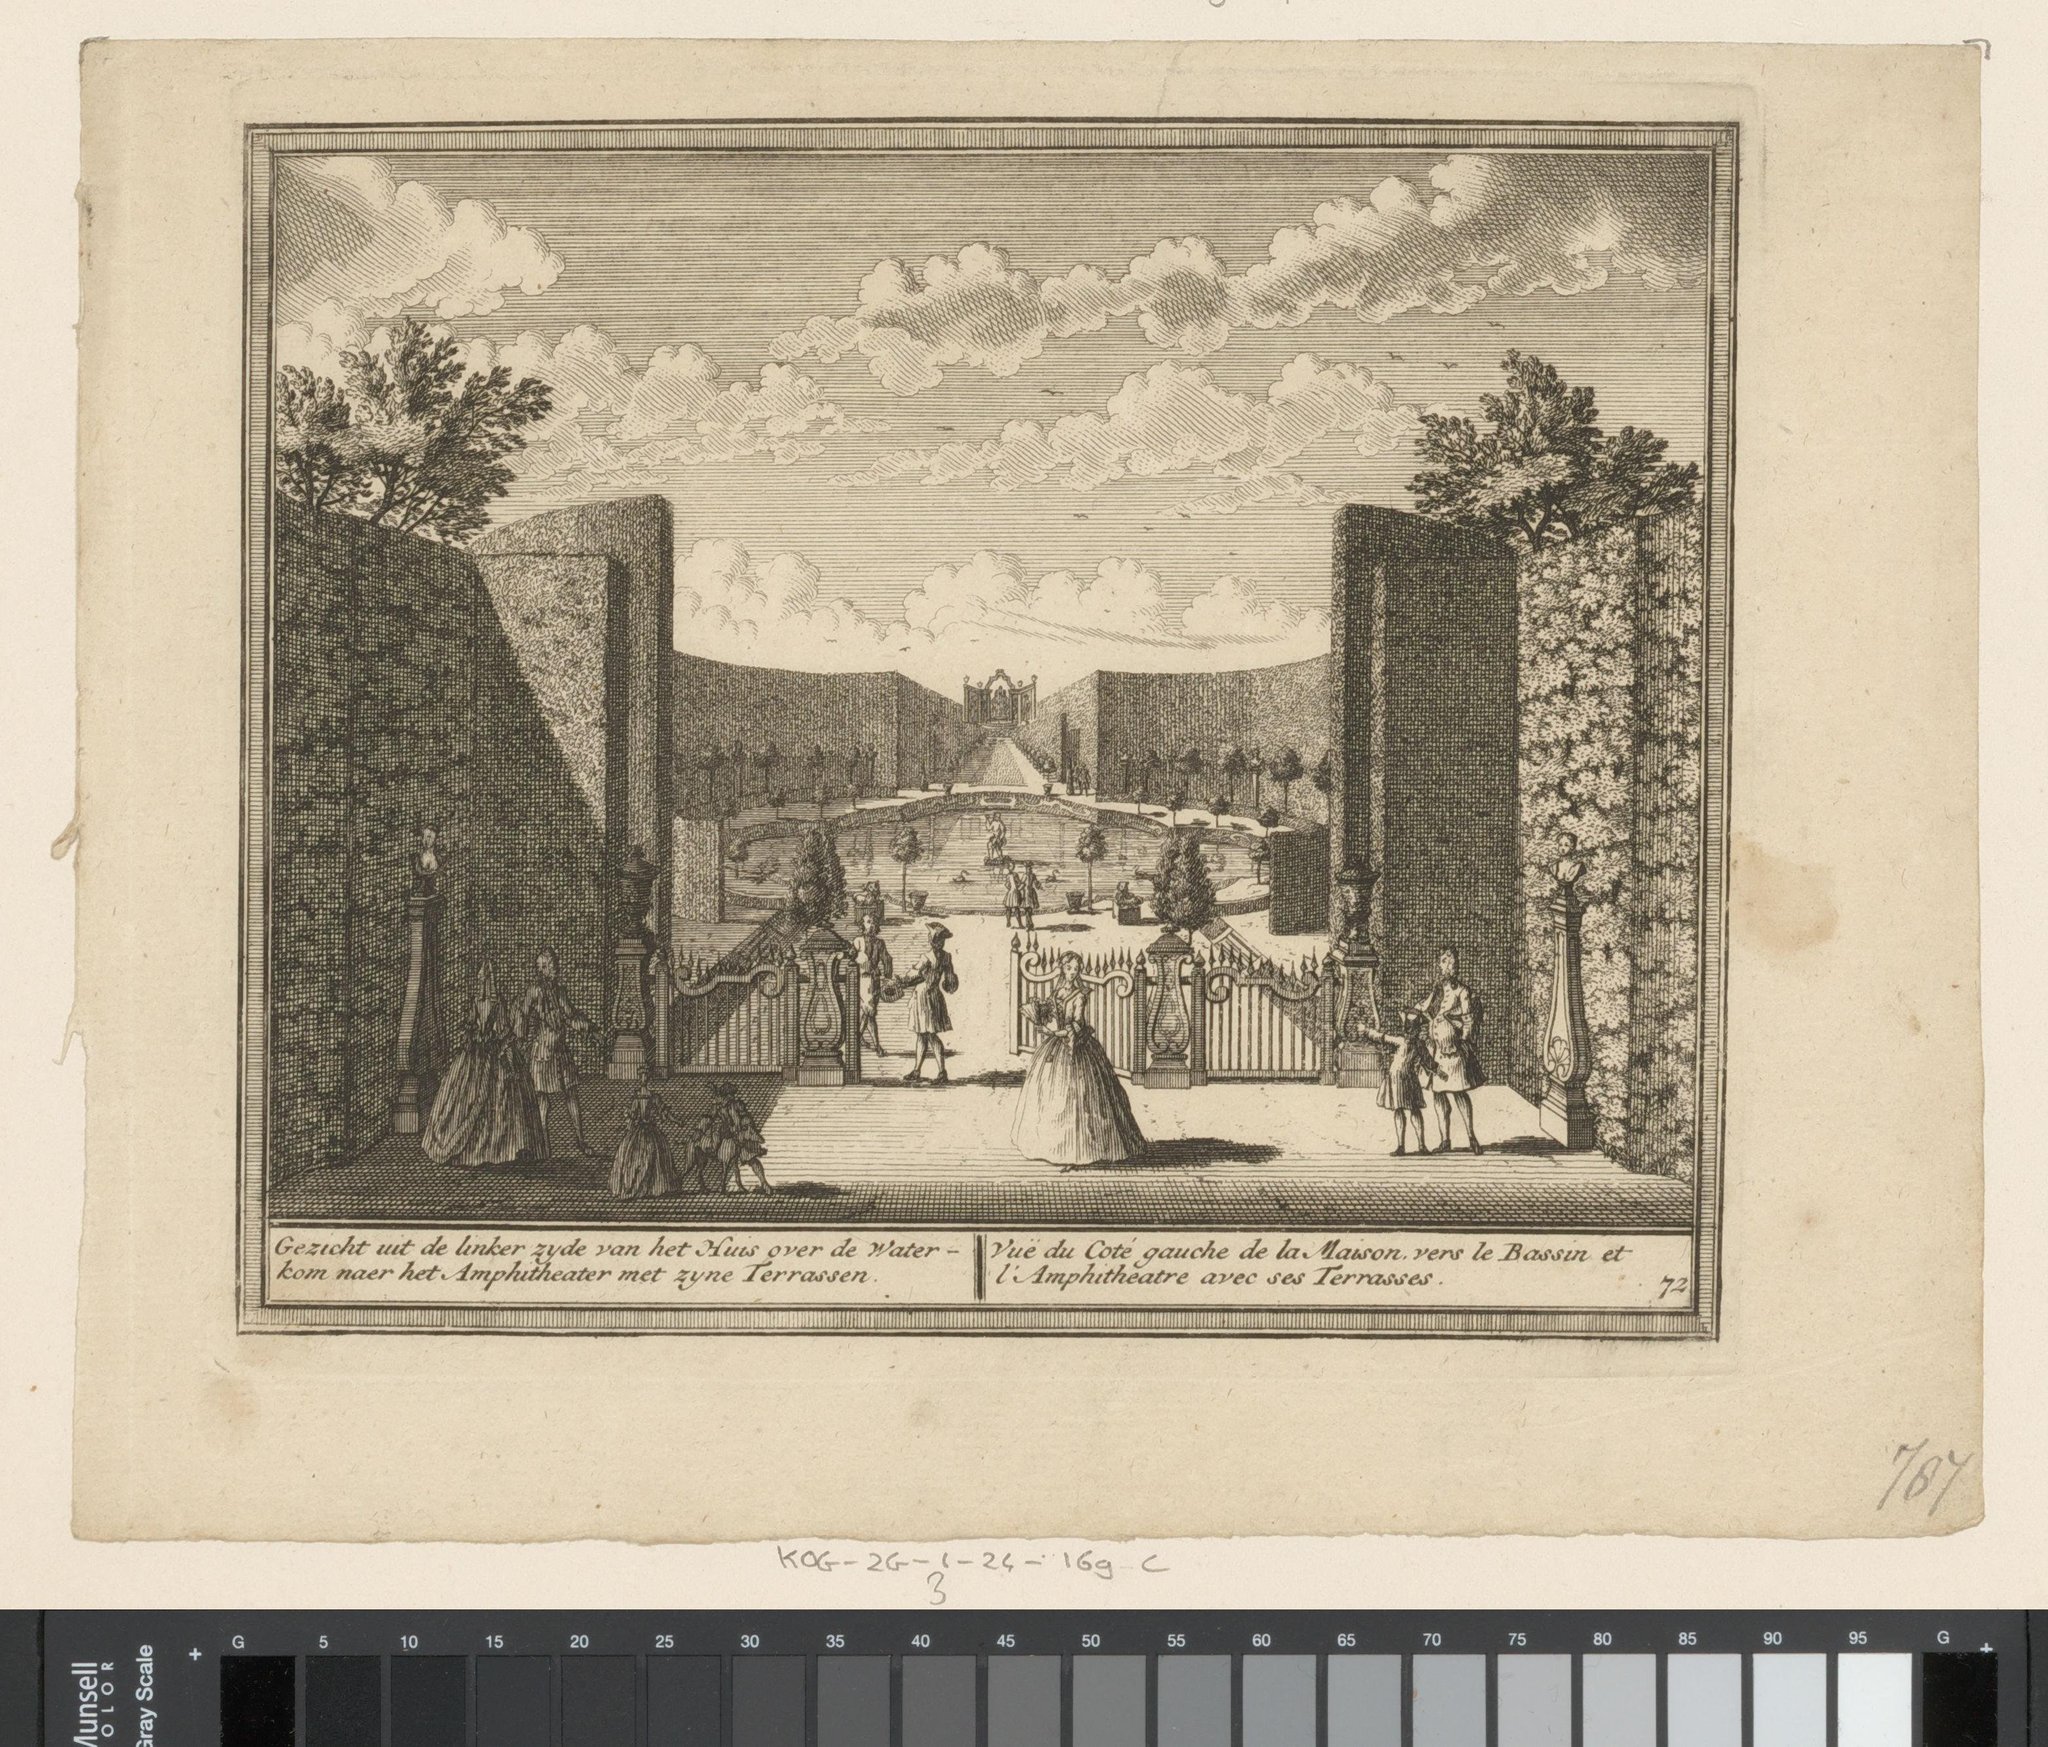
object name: print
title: Uitzicht over de vijver naar het amfitheater van Buitenplaats Velserhooft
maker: hendrik de leth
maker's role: draughtsman, print maker, publisher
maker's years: 1703-1766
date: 1729-1732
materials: paper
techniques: engraving, etching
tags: french or architectonic garden; formal garden, garden pond, country-house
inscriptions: stamp, stamp, collector's mark: Lugt 1641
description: Gezicht van uit het huis Velzerhooft, eigendom van Jacob du Peyrou Jansz, over de vijver naar het amphitheater. Rechtsonder genummerd: 72. Onderwerpsrubrieken binnen de Atlas Zeden en Gewoonten: Zeden en Gewoonten in Engeren Zin, De Woning, Oude Nederlandsche Tuinkunst. De 18de eeuw. Tuinen in Kennemerland, le Nôtre stijl.